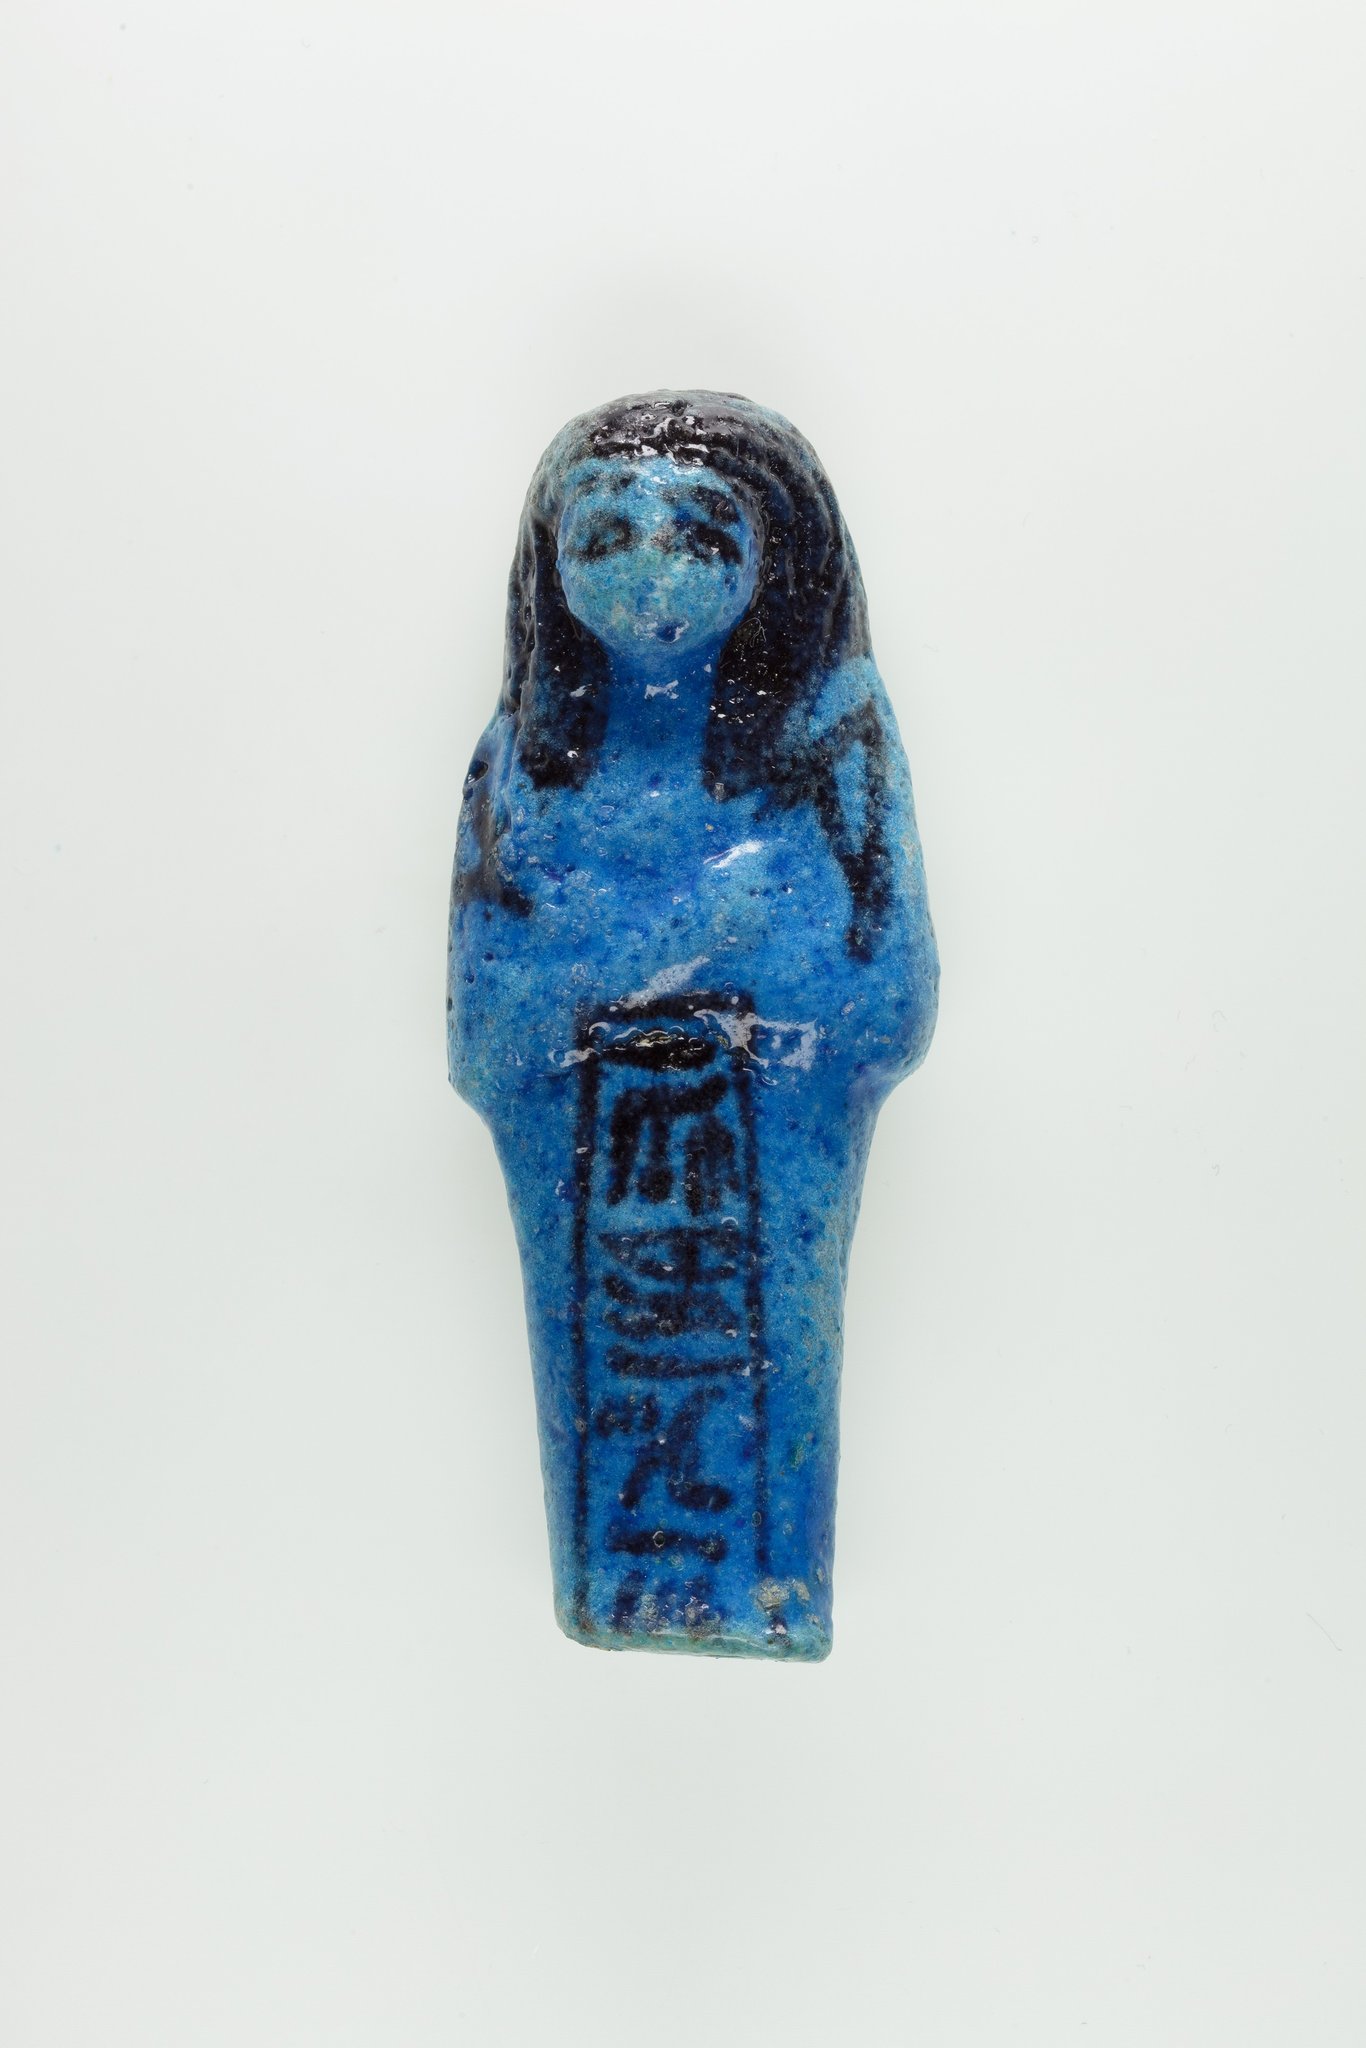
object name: shabti, worker, nauny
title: Worker Shabti of Nauny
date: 1050 BCE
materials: faience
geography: egypt